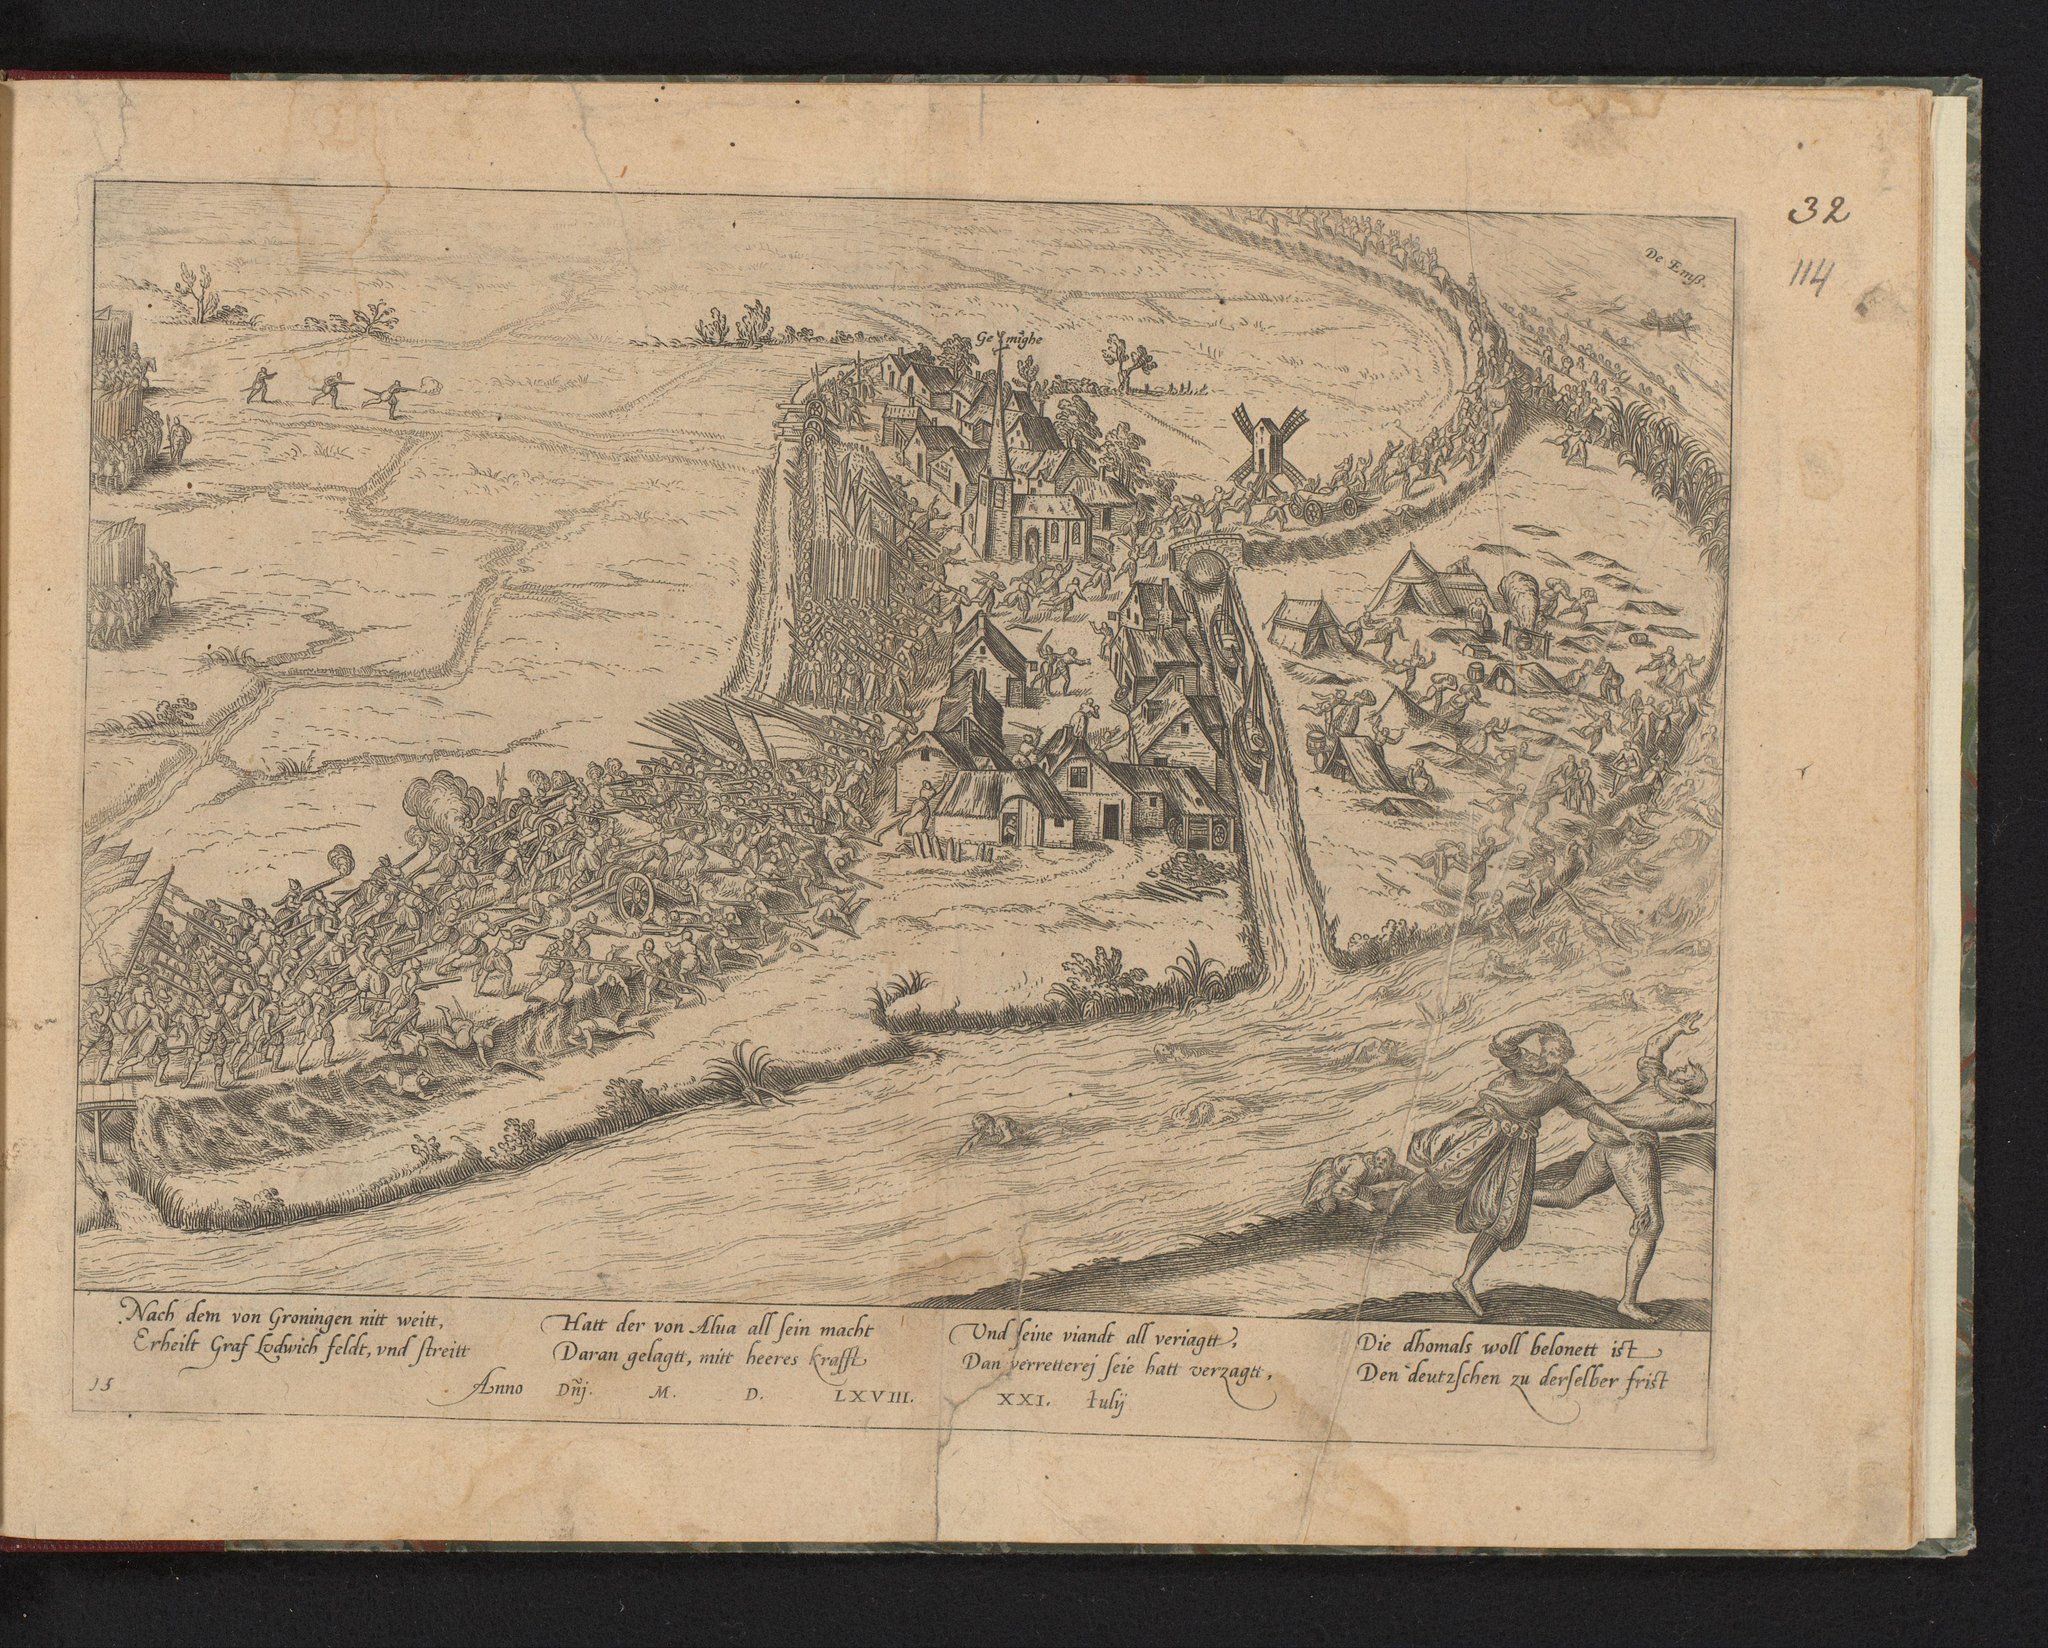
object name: print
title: Serie 5: Nederlandse Gebeurtenissen, 1566-1570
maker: frans hogenberg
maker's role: print maker, publisher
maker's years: 1538-1590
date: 1568-1570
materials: paper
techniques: etching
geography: cologne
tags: fernando álvarez de toledo (3rd duke of alba), battle, fighting in general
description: Slag bij Jemmingen, 21 juli 1568. Het leger van Lodewijk van Nassau wordt door Alva verslagen bij het dorpje Jemmingen. Sommigen redden zich door in het water van de rivier de Eems te springen. Met onderschrift van 8 regels in het Duits. Genummerd: 14. De prent maakt deel uit van een album.